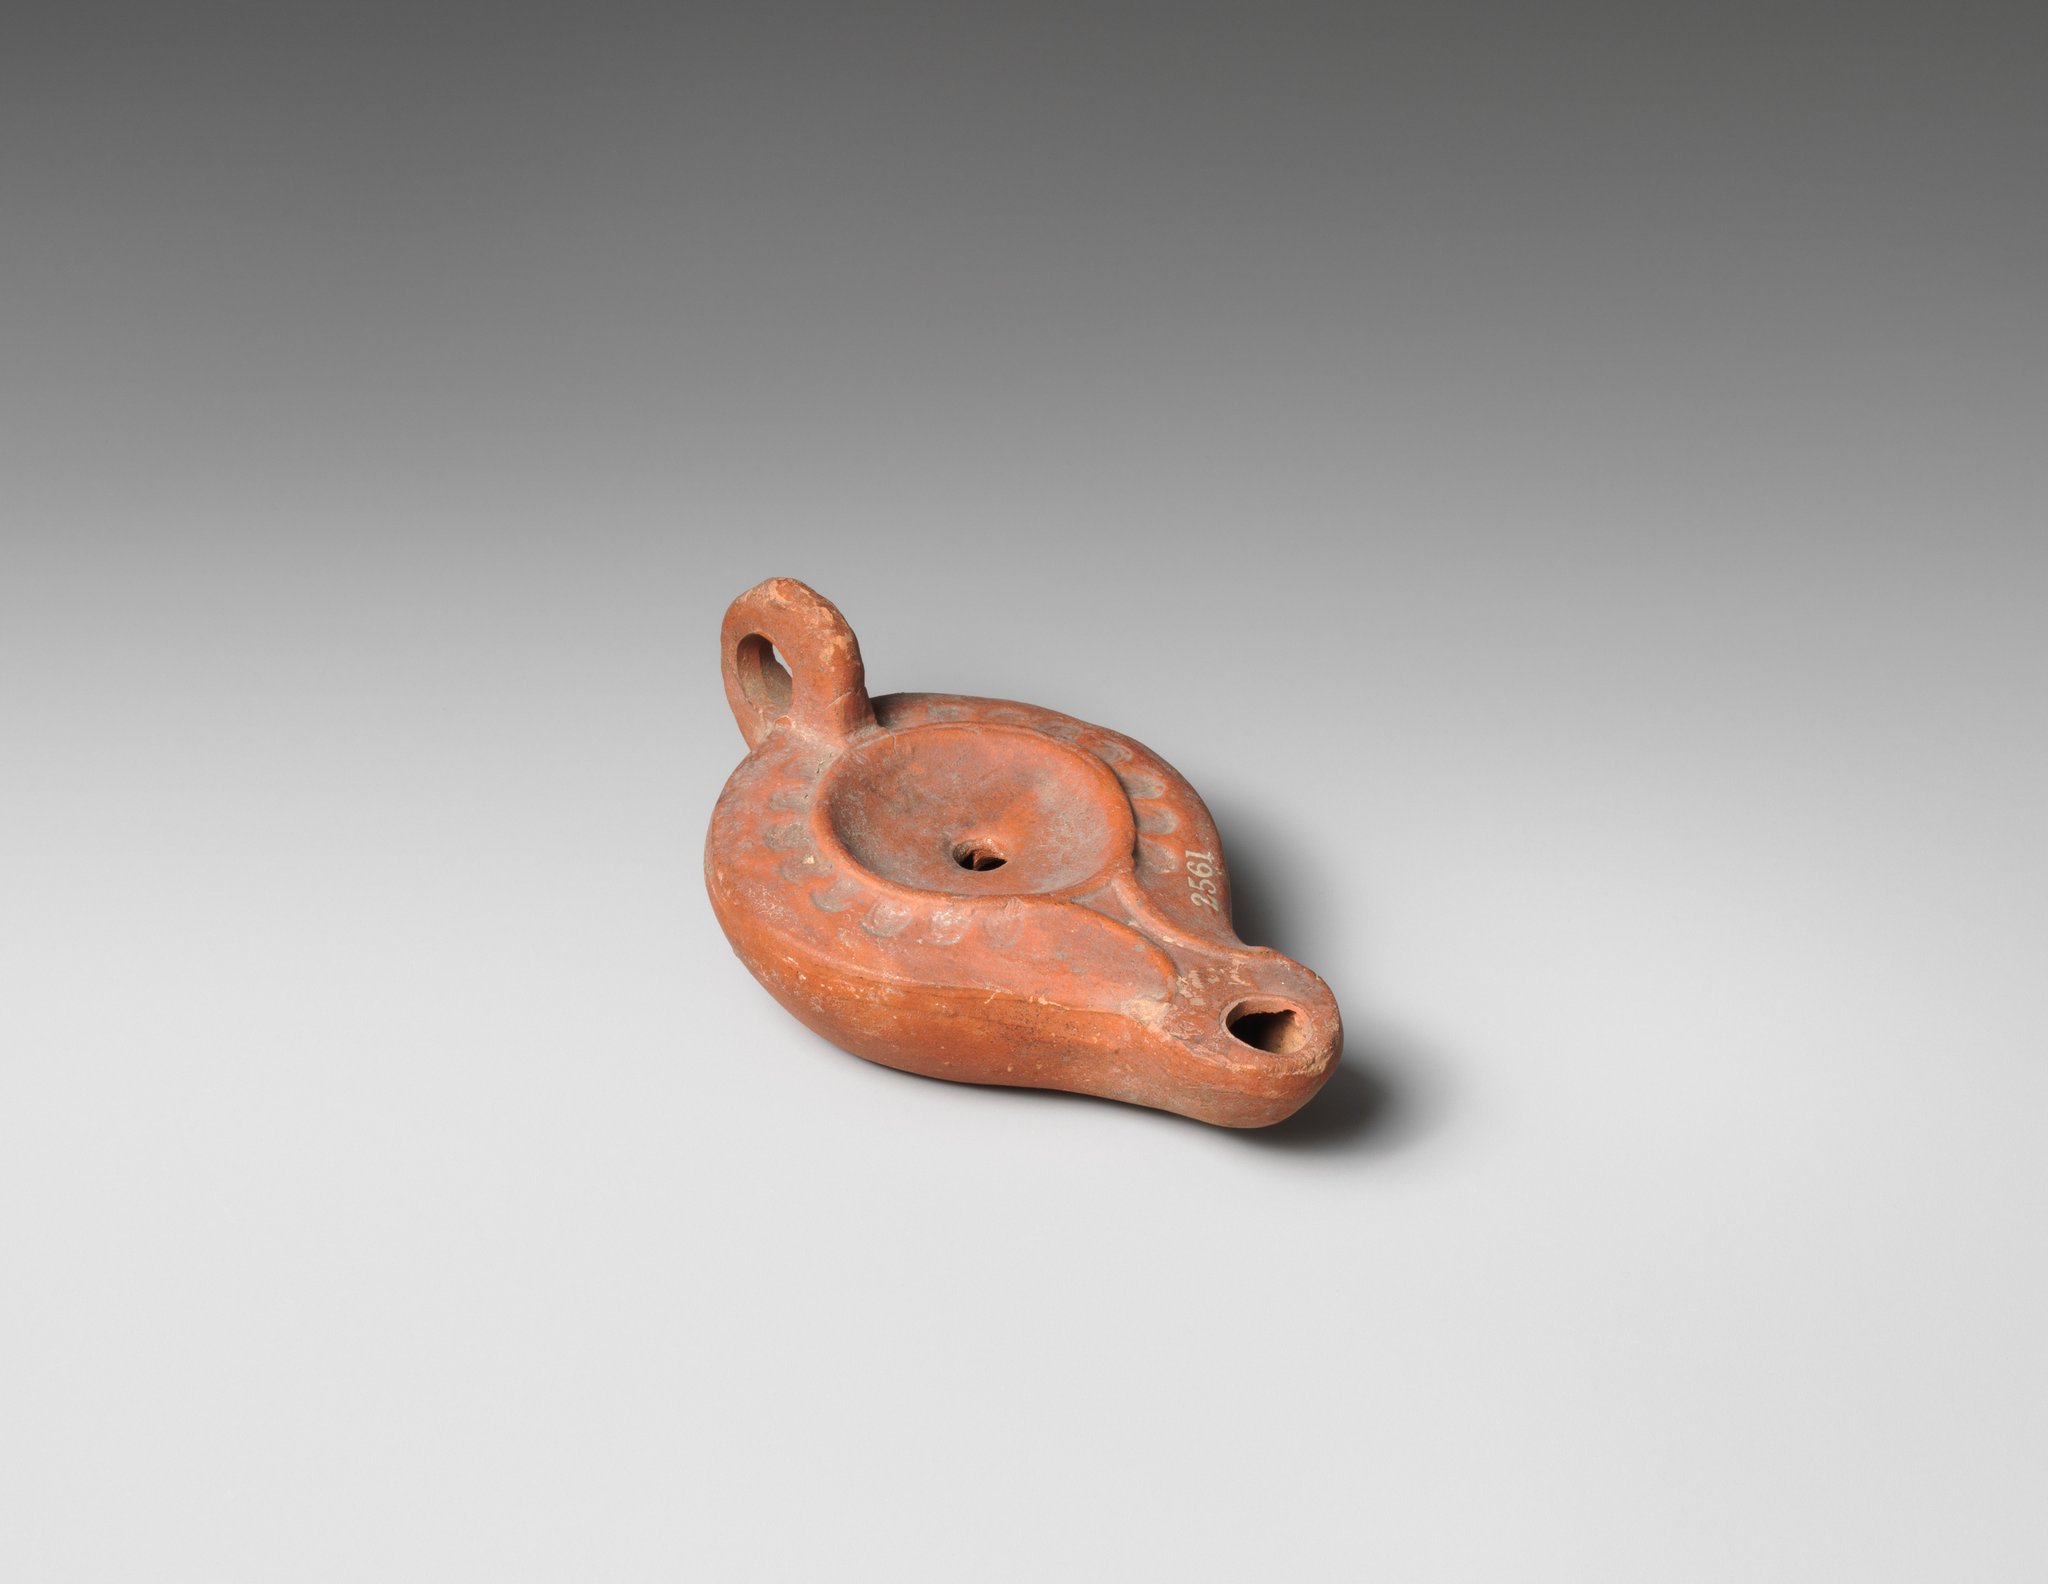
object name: lamp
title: Terracotta oil lamp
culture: roman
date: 100 BCE-100 CE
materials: terracotta